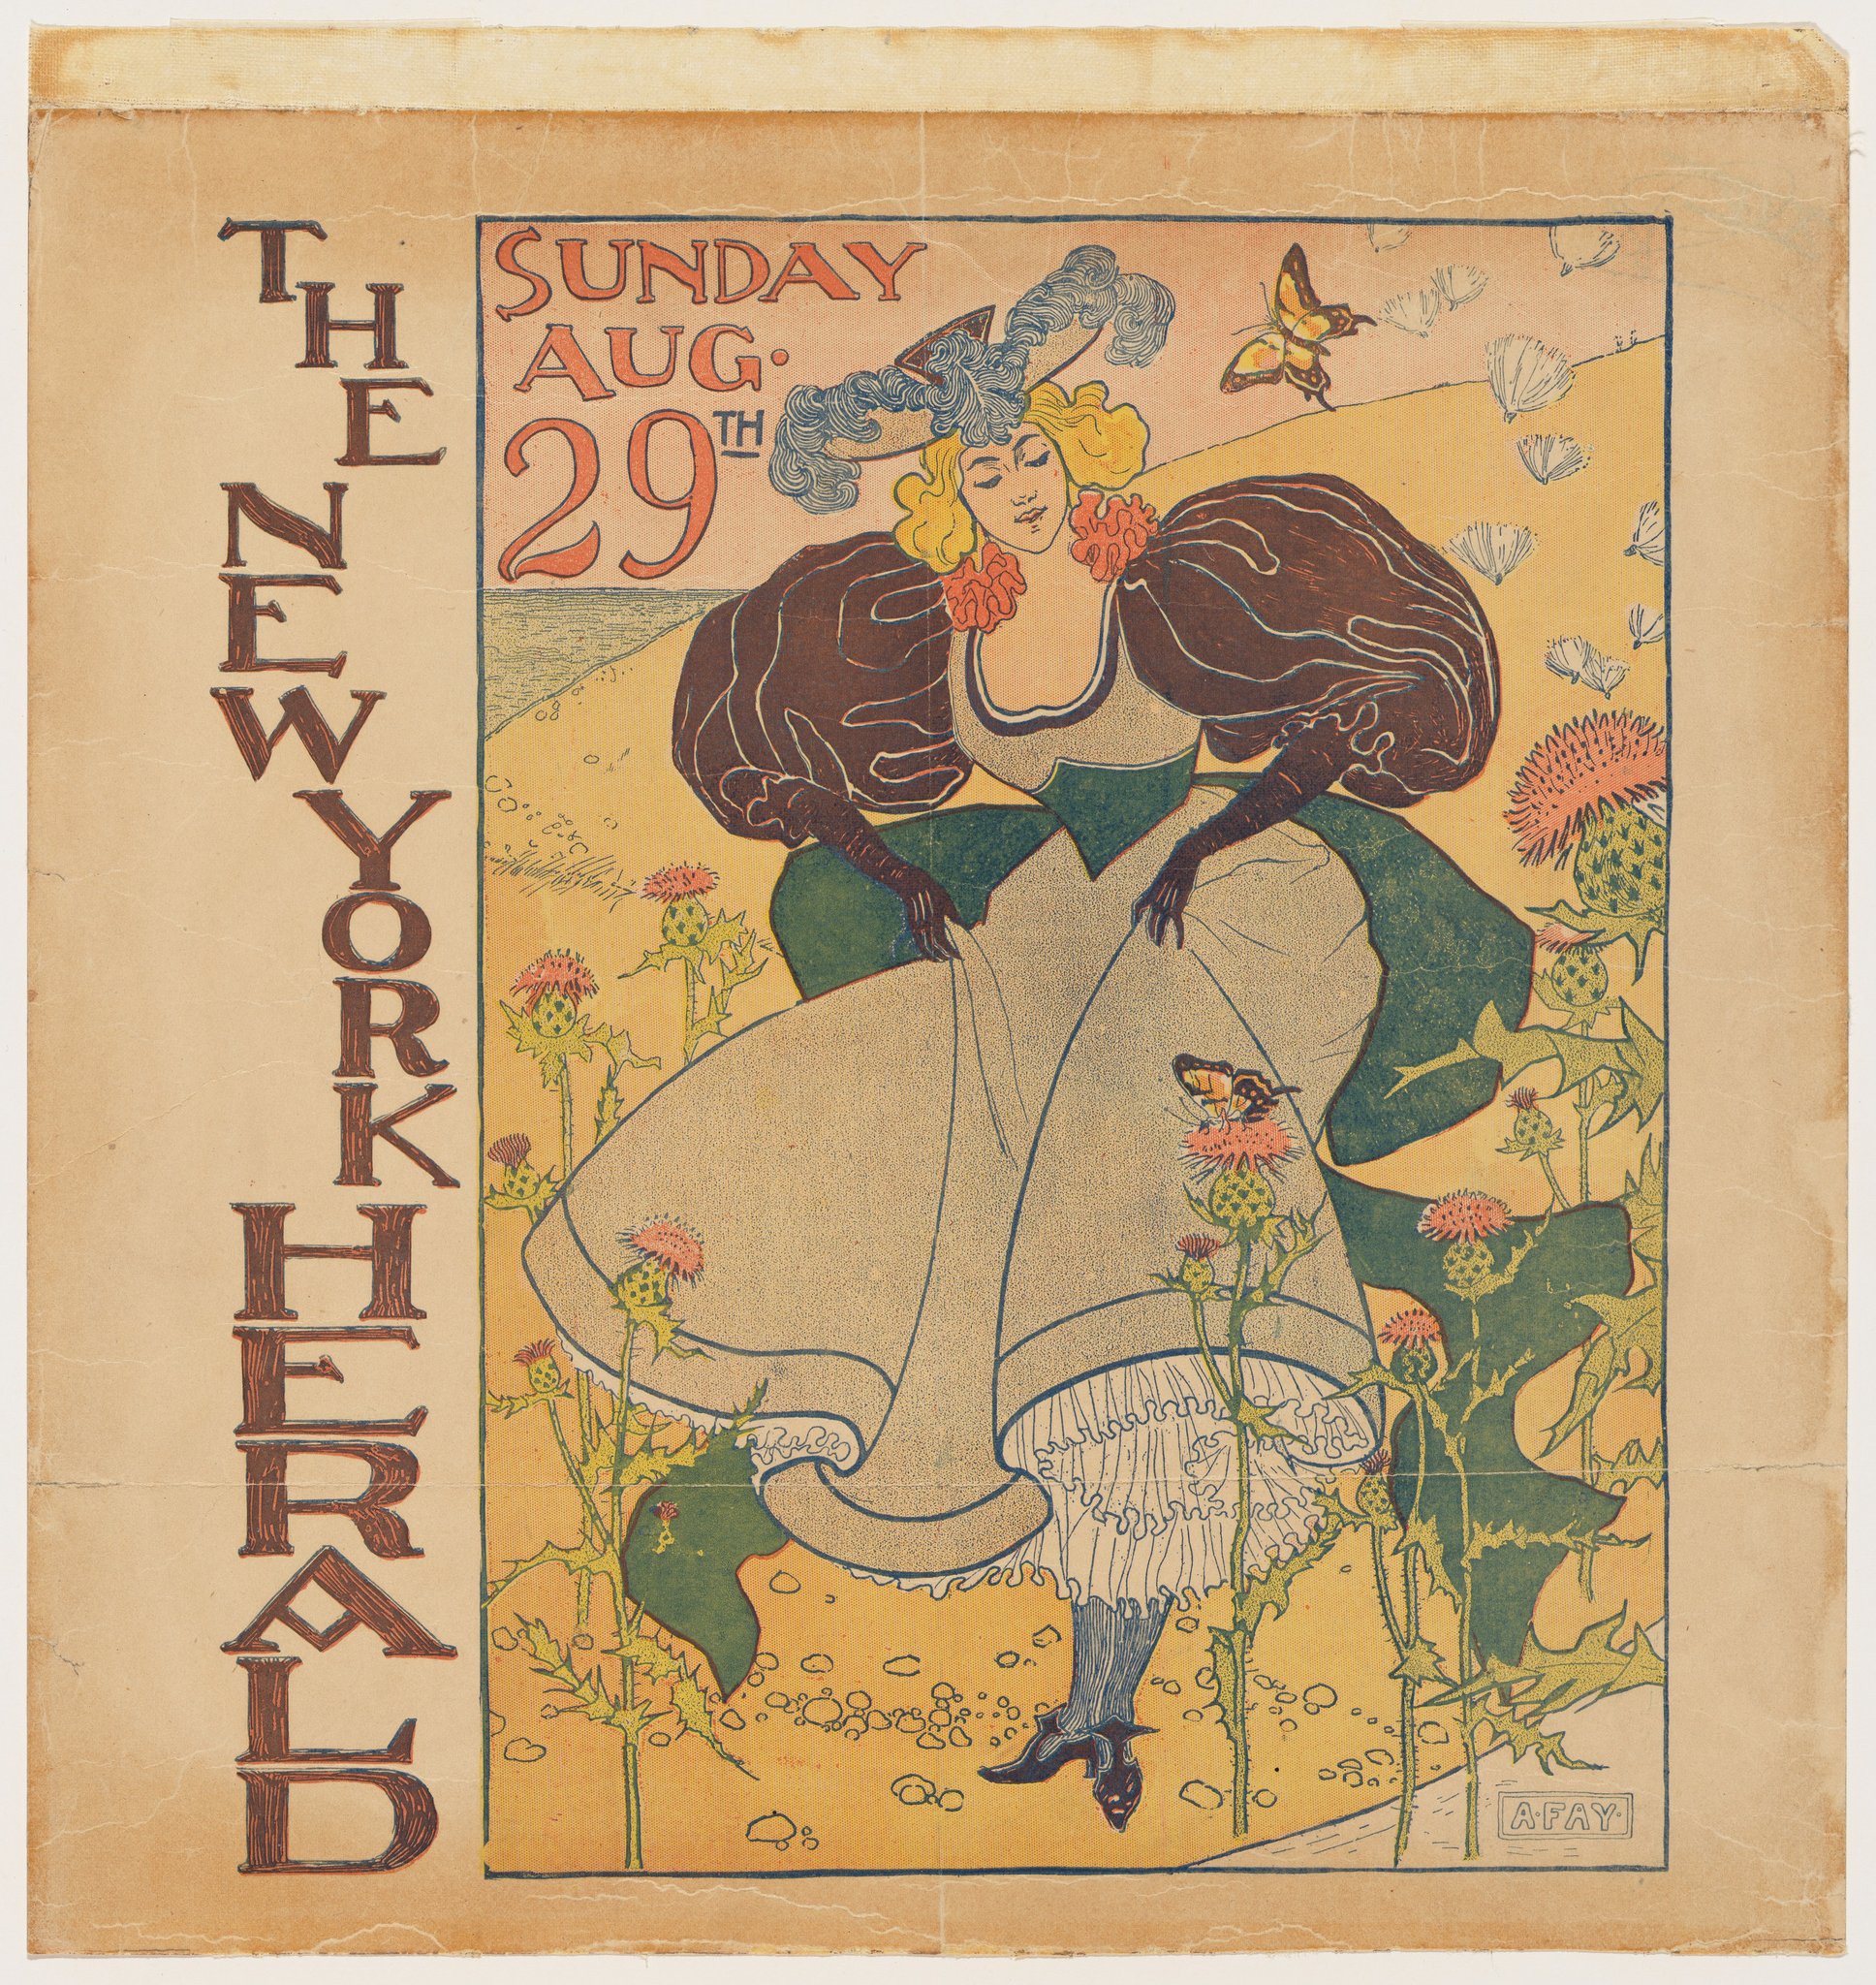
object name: poster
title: The New York Herald, Sunday, August 29th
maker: a. fay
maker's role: artist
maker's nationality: american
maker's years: 1870-1910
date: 1897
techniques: lithograph